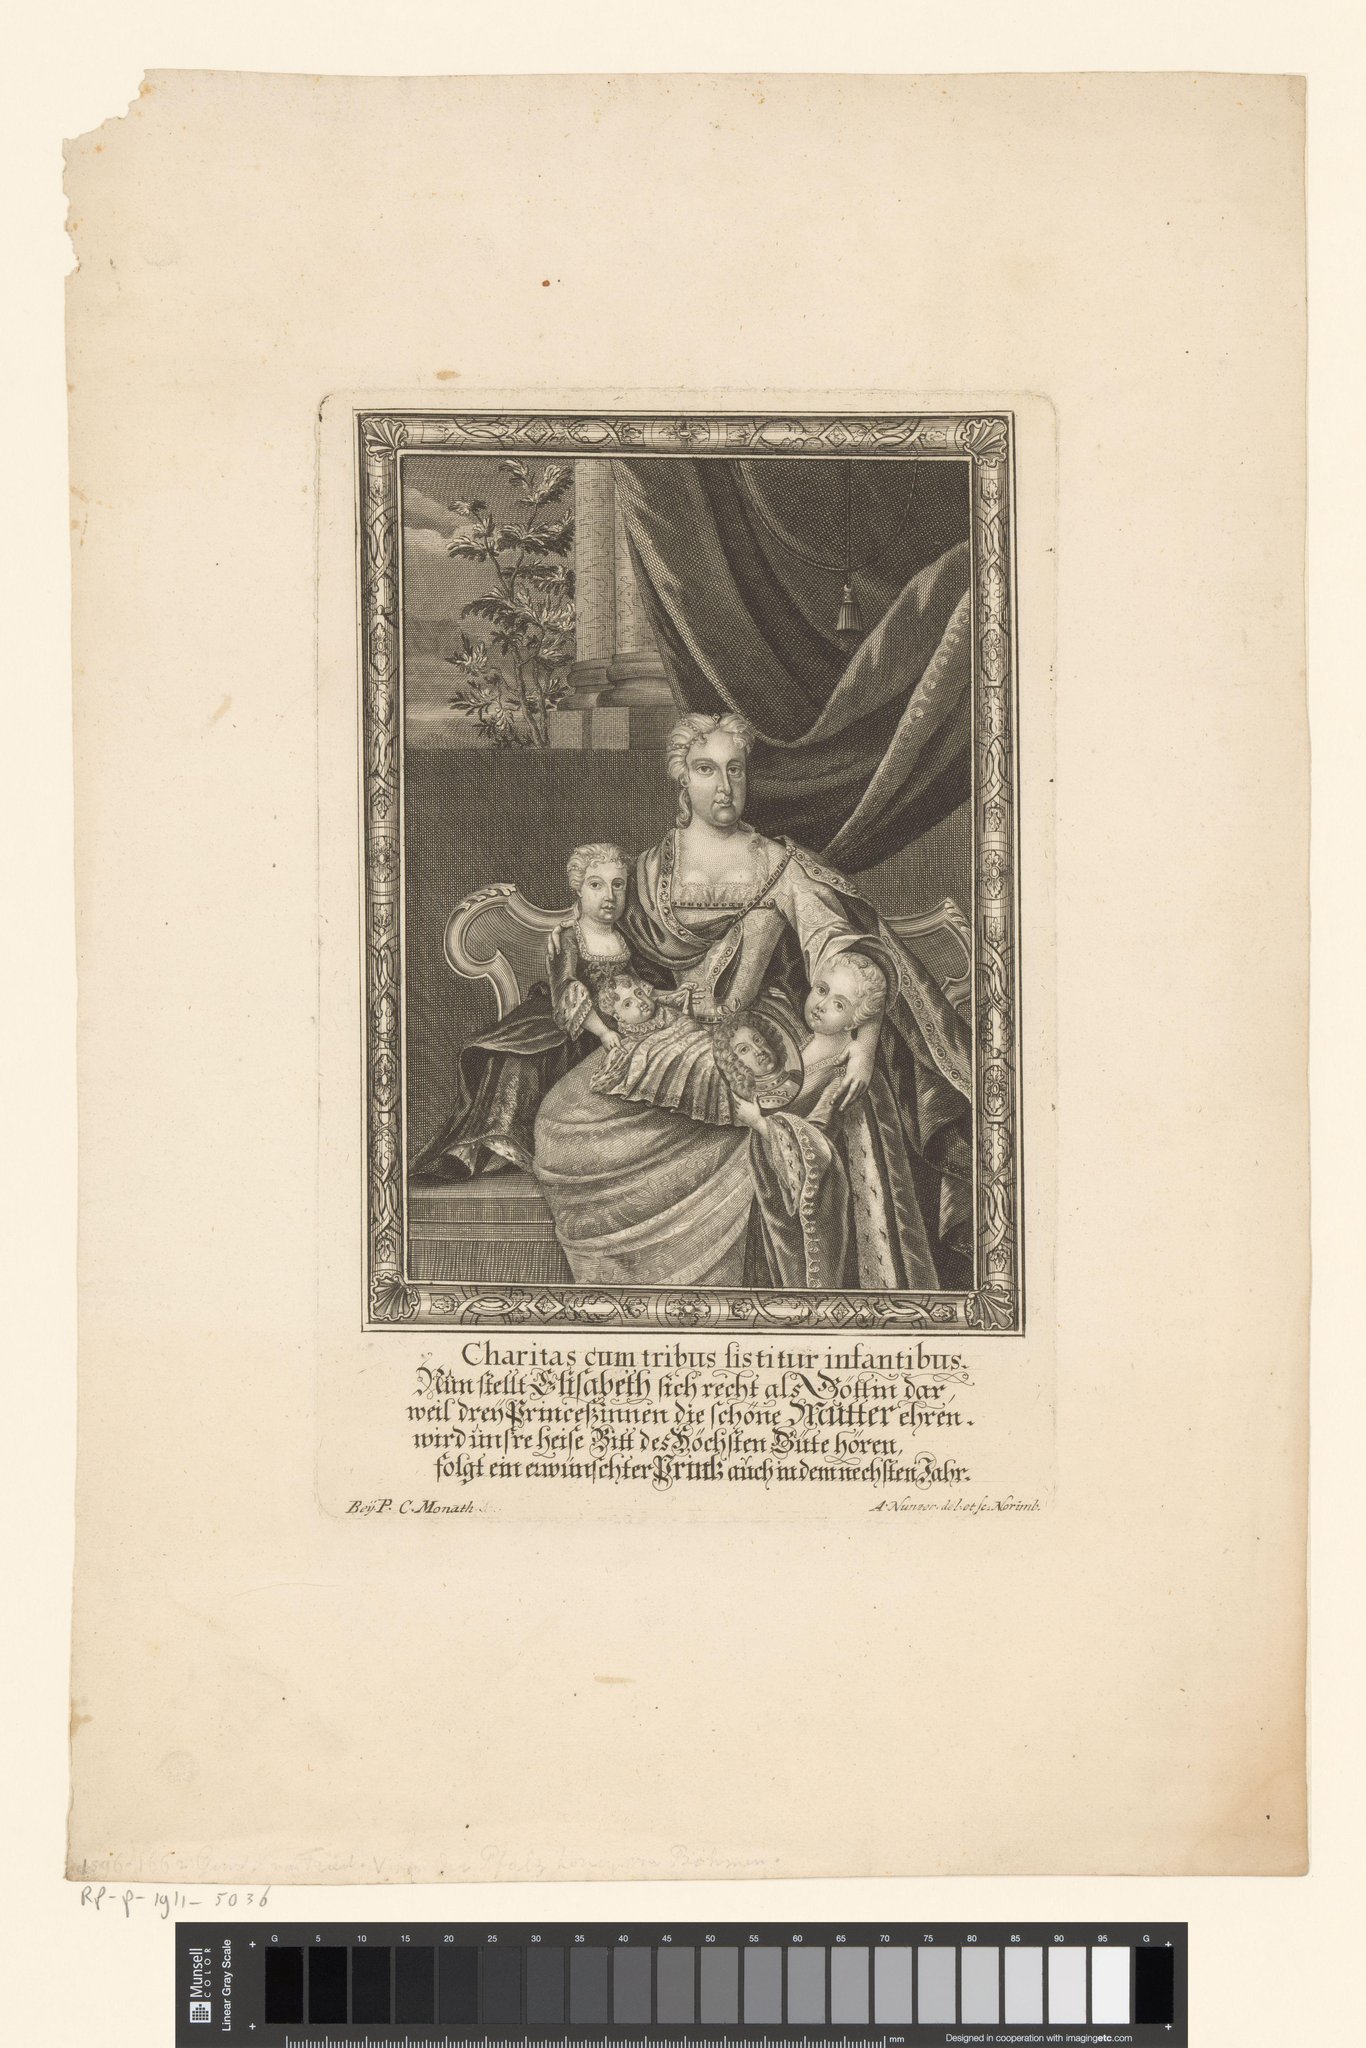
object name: print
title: Groepsportret van Elisabeth Christine van Brunswijk en haar gezin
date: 1700-1749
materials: paper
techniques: engraving, etching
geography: nuremberg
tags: vienna, maria theresia (rooms-duits keizerin), brussels, charles vi (holy roman emperor), historical persons - bb - woman, historical person (with name) - bb - woman - historical person (with name) portrayed in a group, in a group-portrait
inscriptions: collector's mark: Lugt 2228